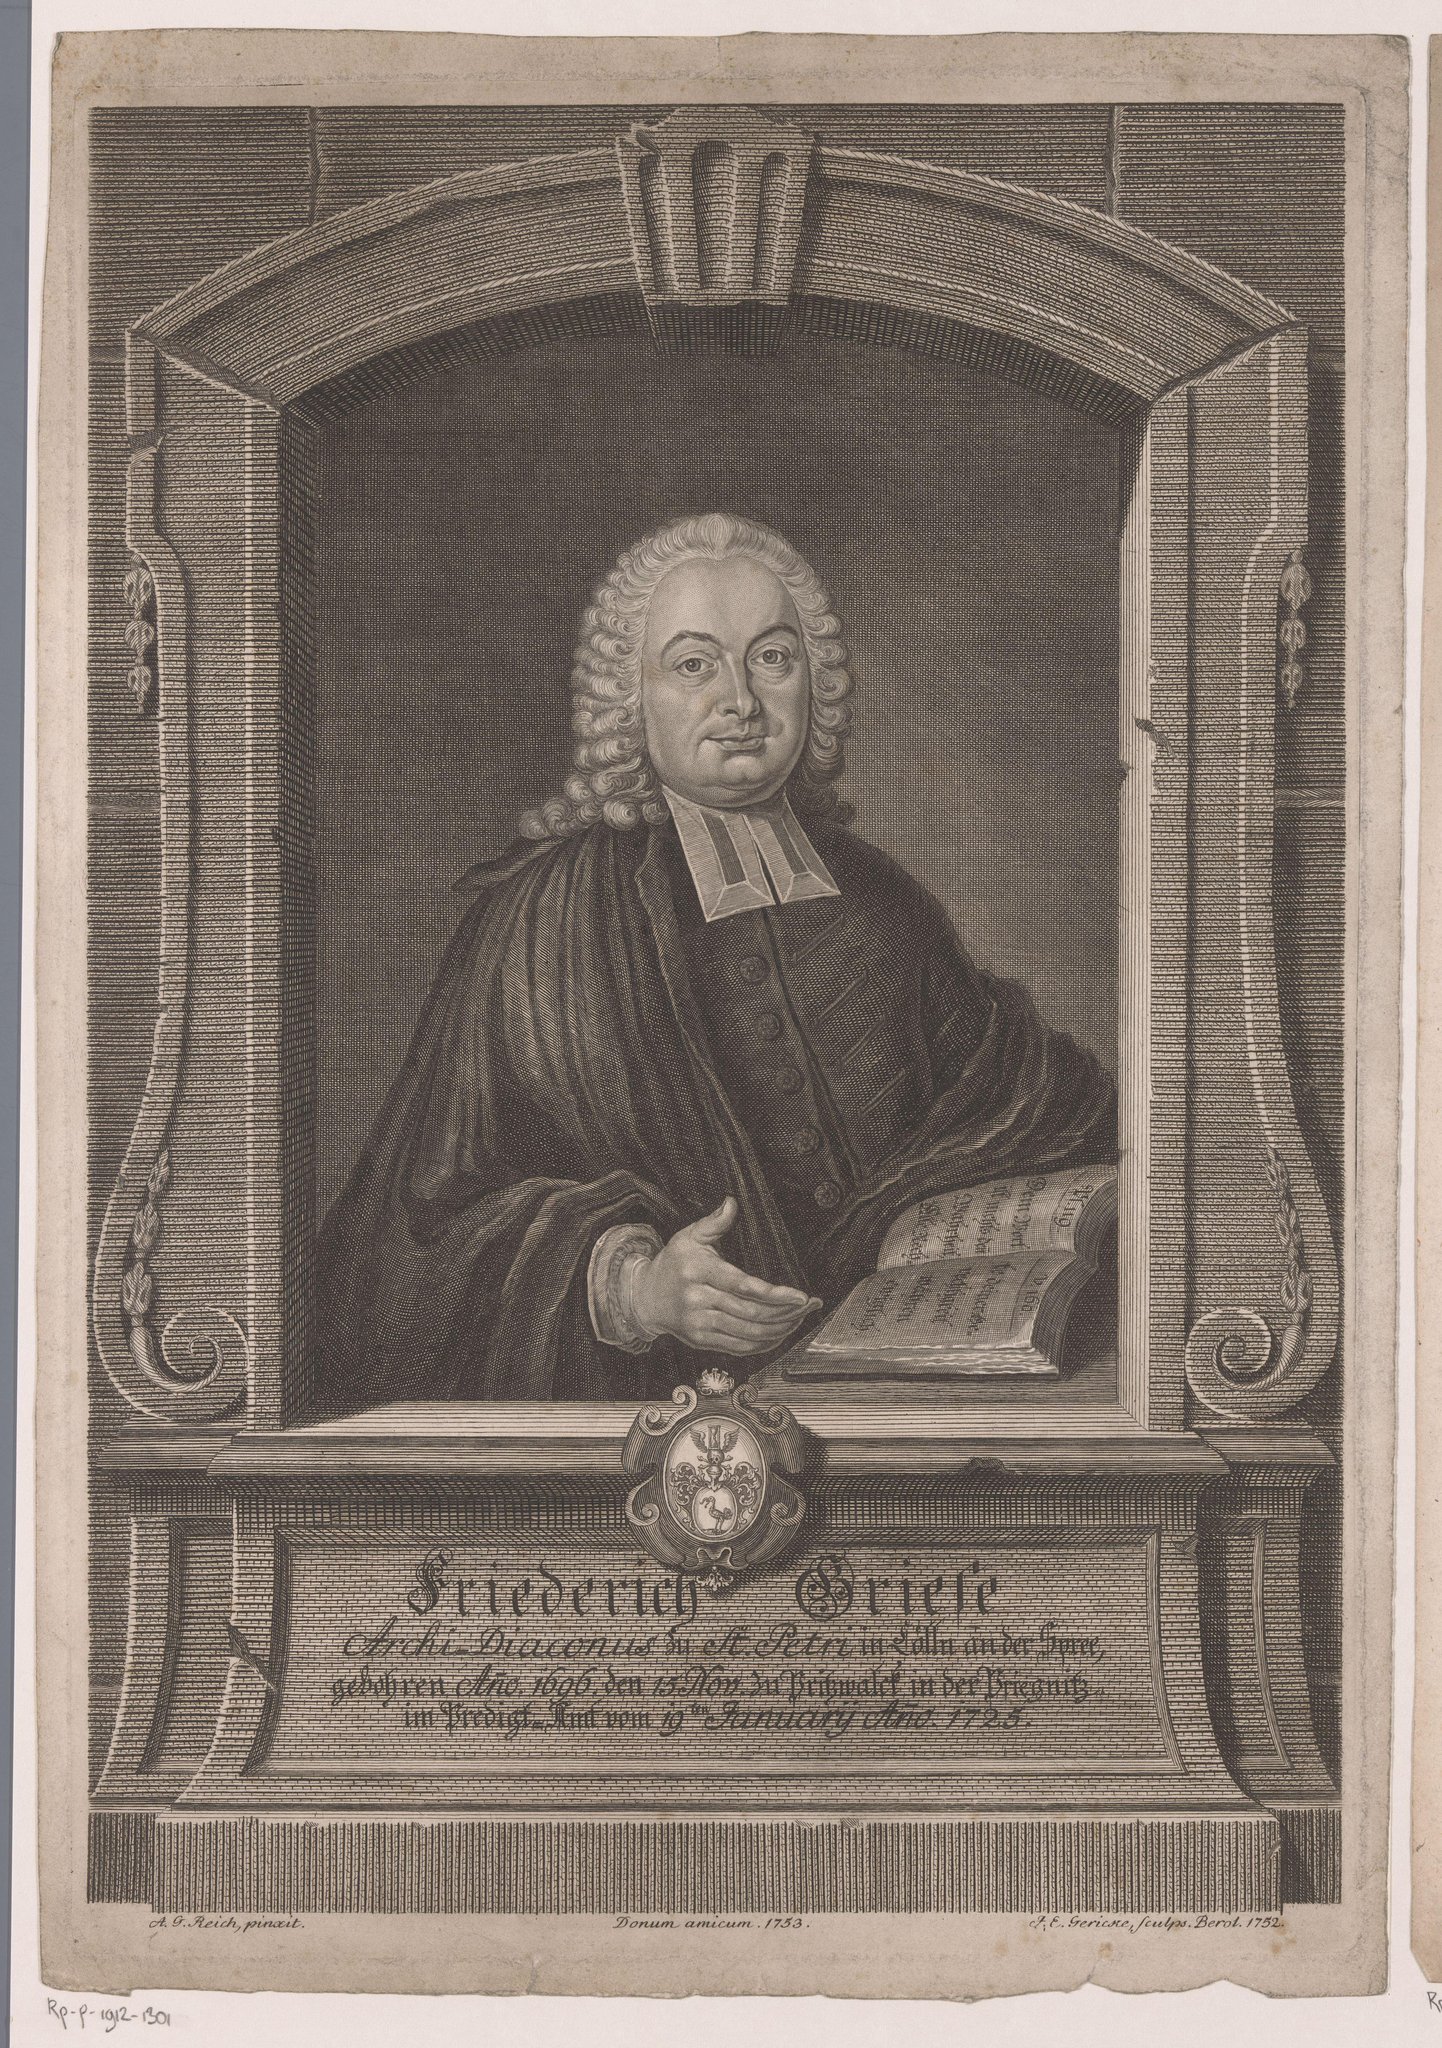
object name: print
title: Portret van Friedrich Griese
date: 1752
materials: paper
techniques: engraving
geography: berlin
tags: theologian, historical persons, book, ornament derived from architectural details, armorial bearing, heraldry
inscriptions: collector's mark: Lugt 2228